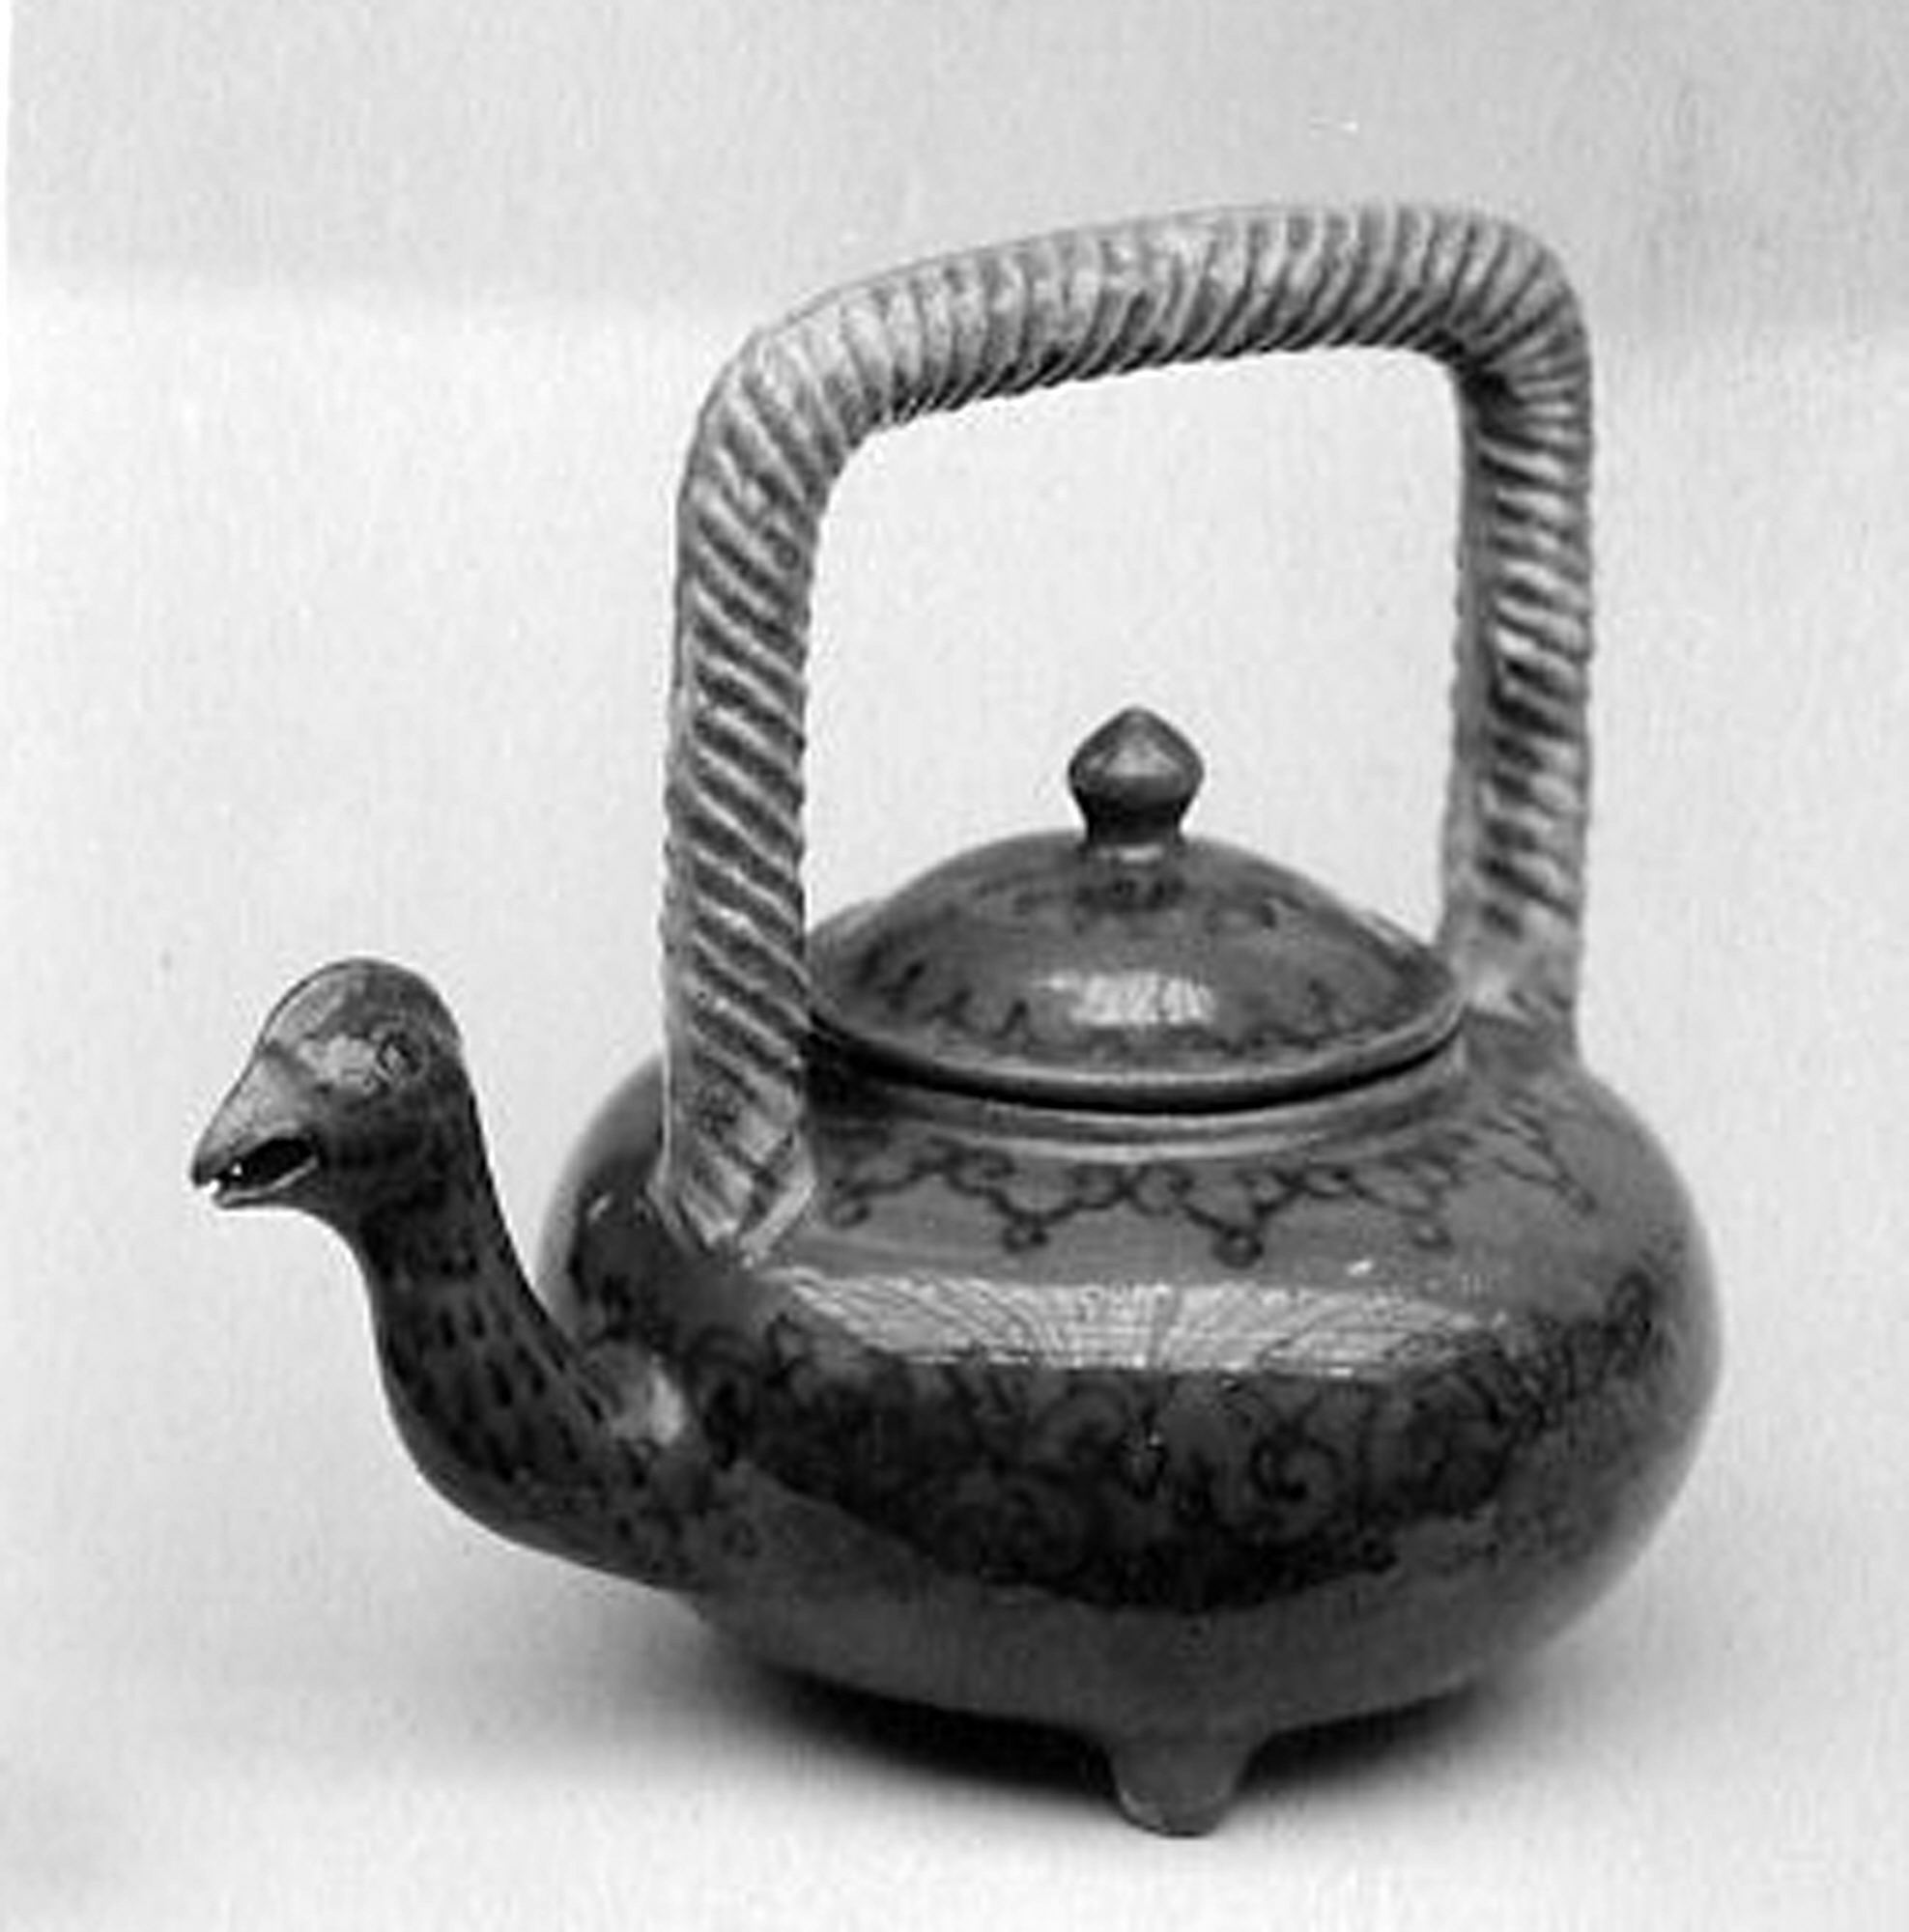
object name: teapot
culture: chinese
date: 1662-1722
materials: porcelain